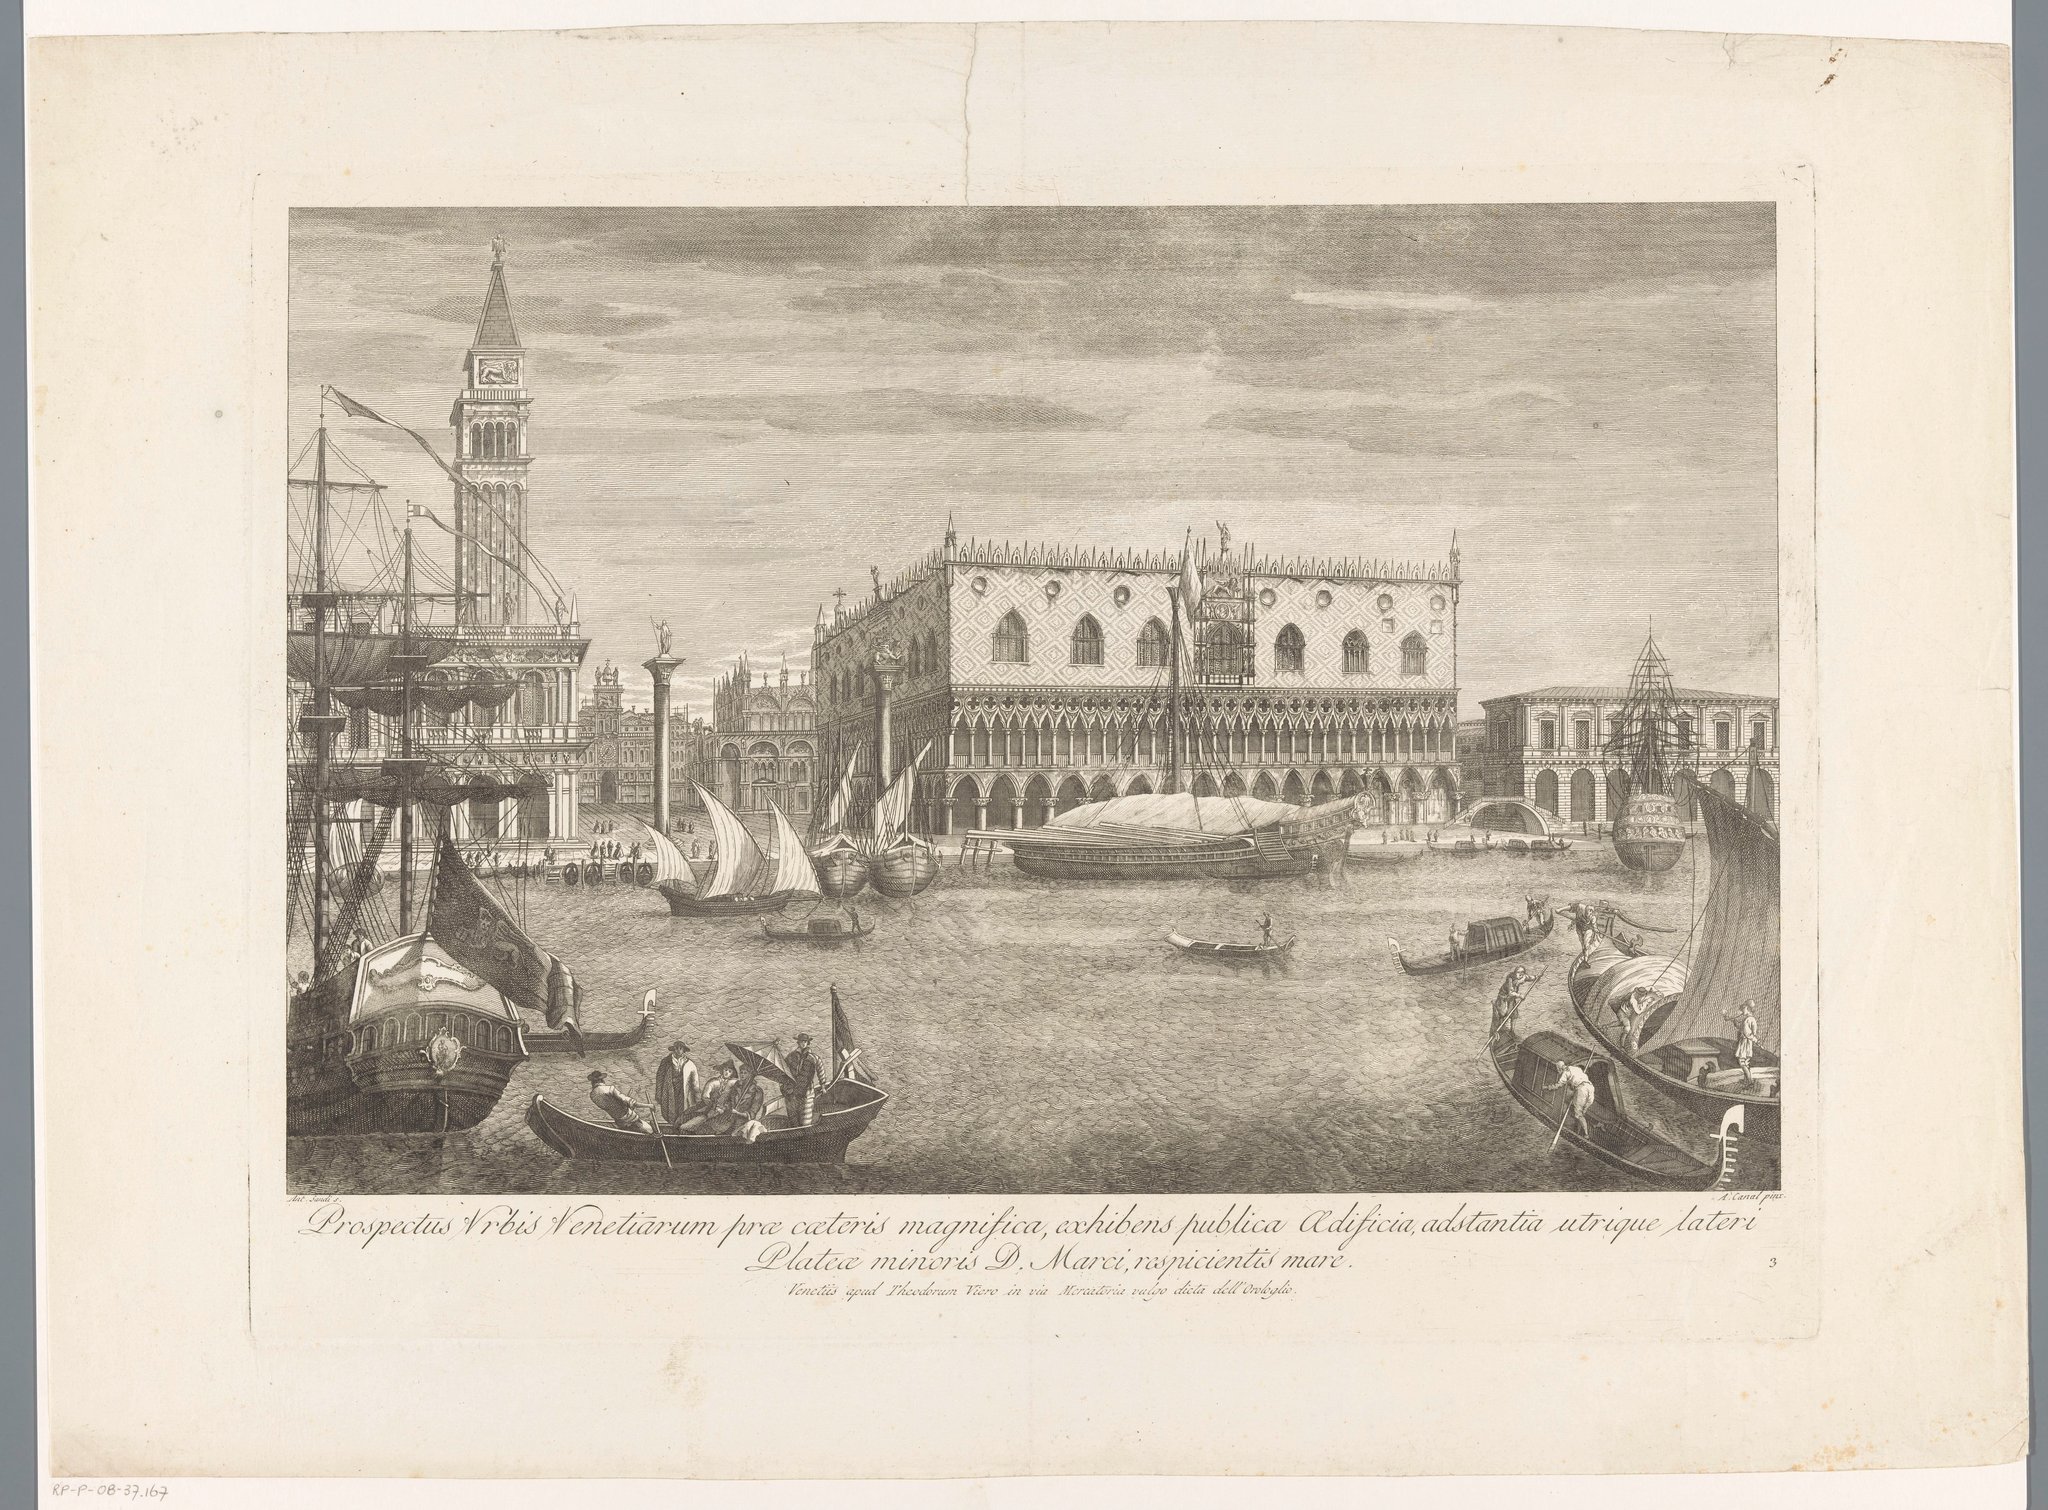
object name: print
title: Gezichten op Venetië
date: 1743-1817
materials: paper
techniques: engraving, etching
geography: venice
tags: parts of church exterior and annexes: campanile, city-view, and landscape with man-made constructions, canal, palace, church (exterior)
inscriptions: collector's mark: Lugt 2228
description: Gezicht vanaf het Canal Grande op het Dogepaleis aan de Riva degli Schiavoni te Venetië. Op de achtergrond de San Marco en de Campanile di San Marco. Titel in het Latijn in ondermarge. Genummerd rechtsonder: 3.